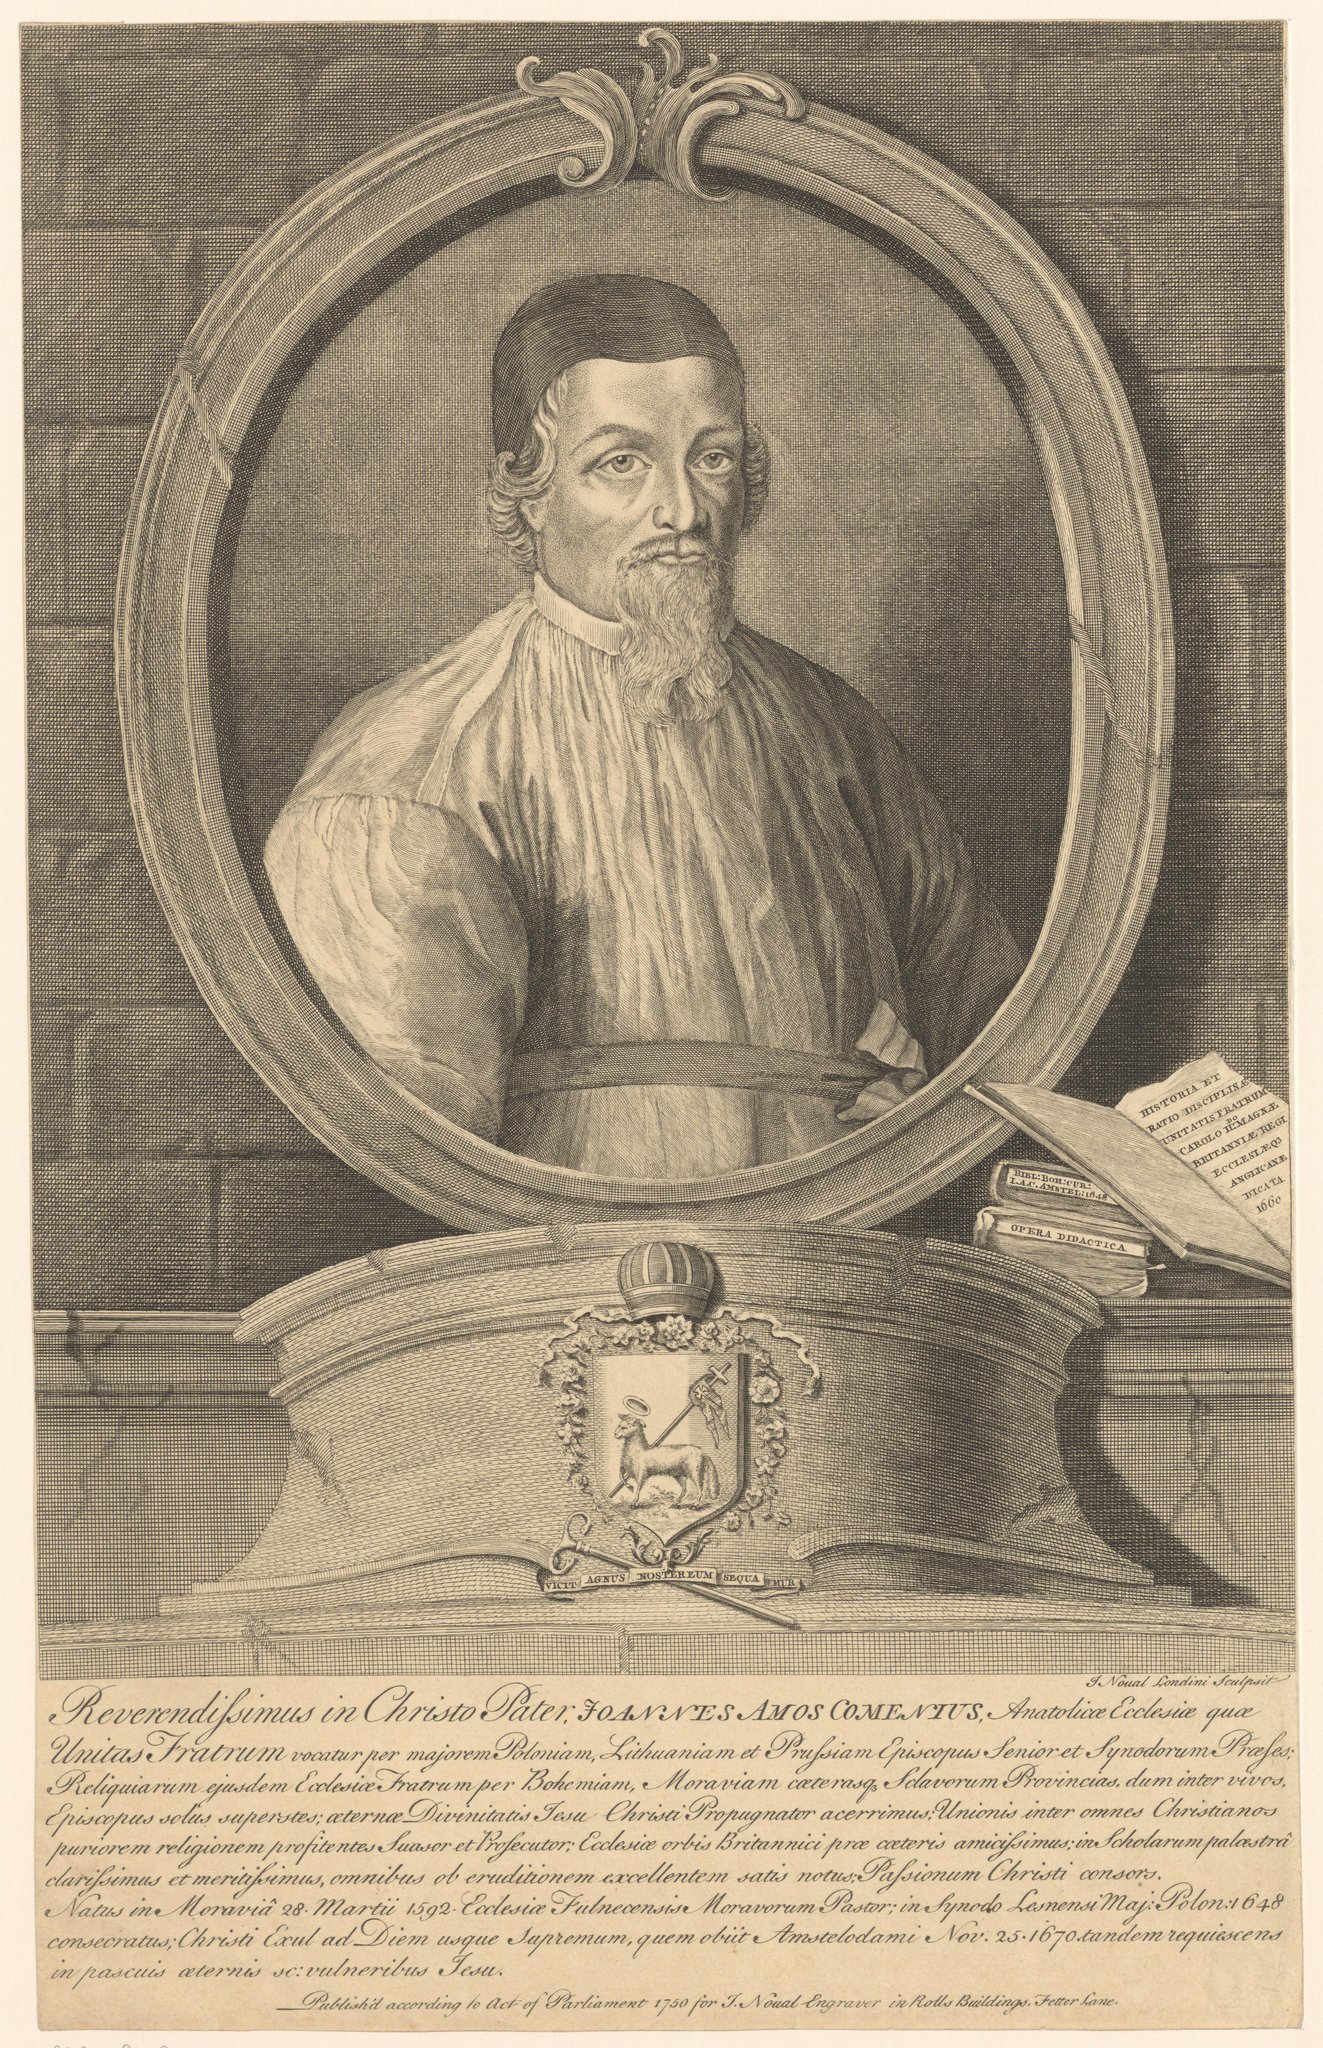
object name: print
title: Joannes Amos Comenius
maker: j. noual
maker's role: print maker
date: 1750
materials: paper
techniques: engraving, etching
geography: london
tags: theologian, historical persons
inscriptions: collector's mark: Lugt 2228